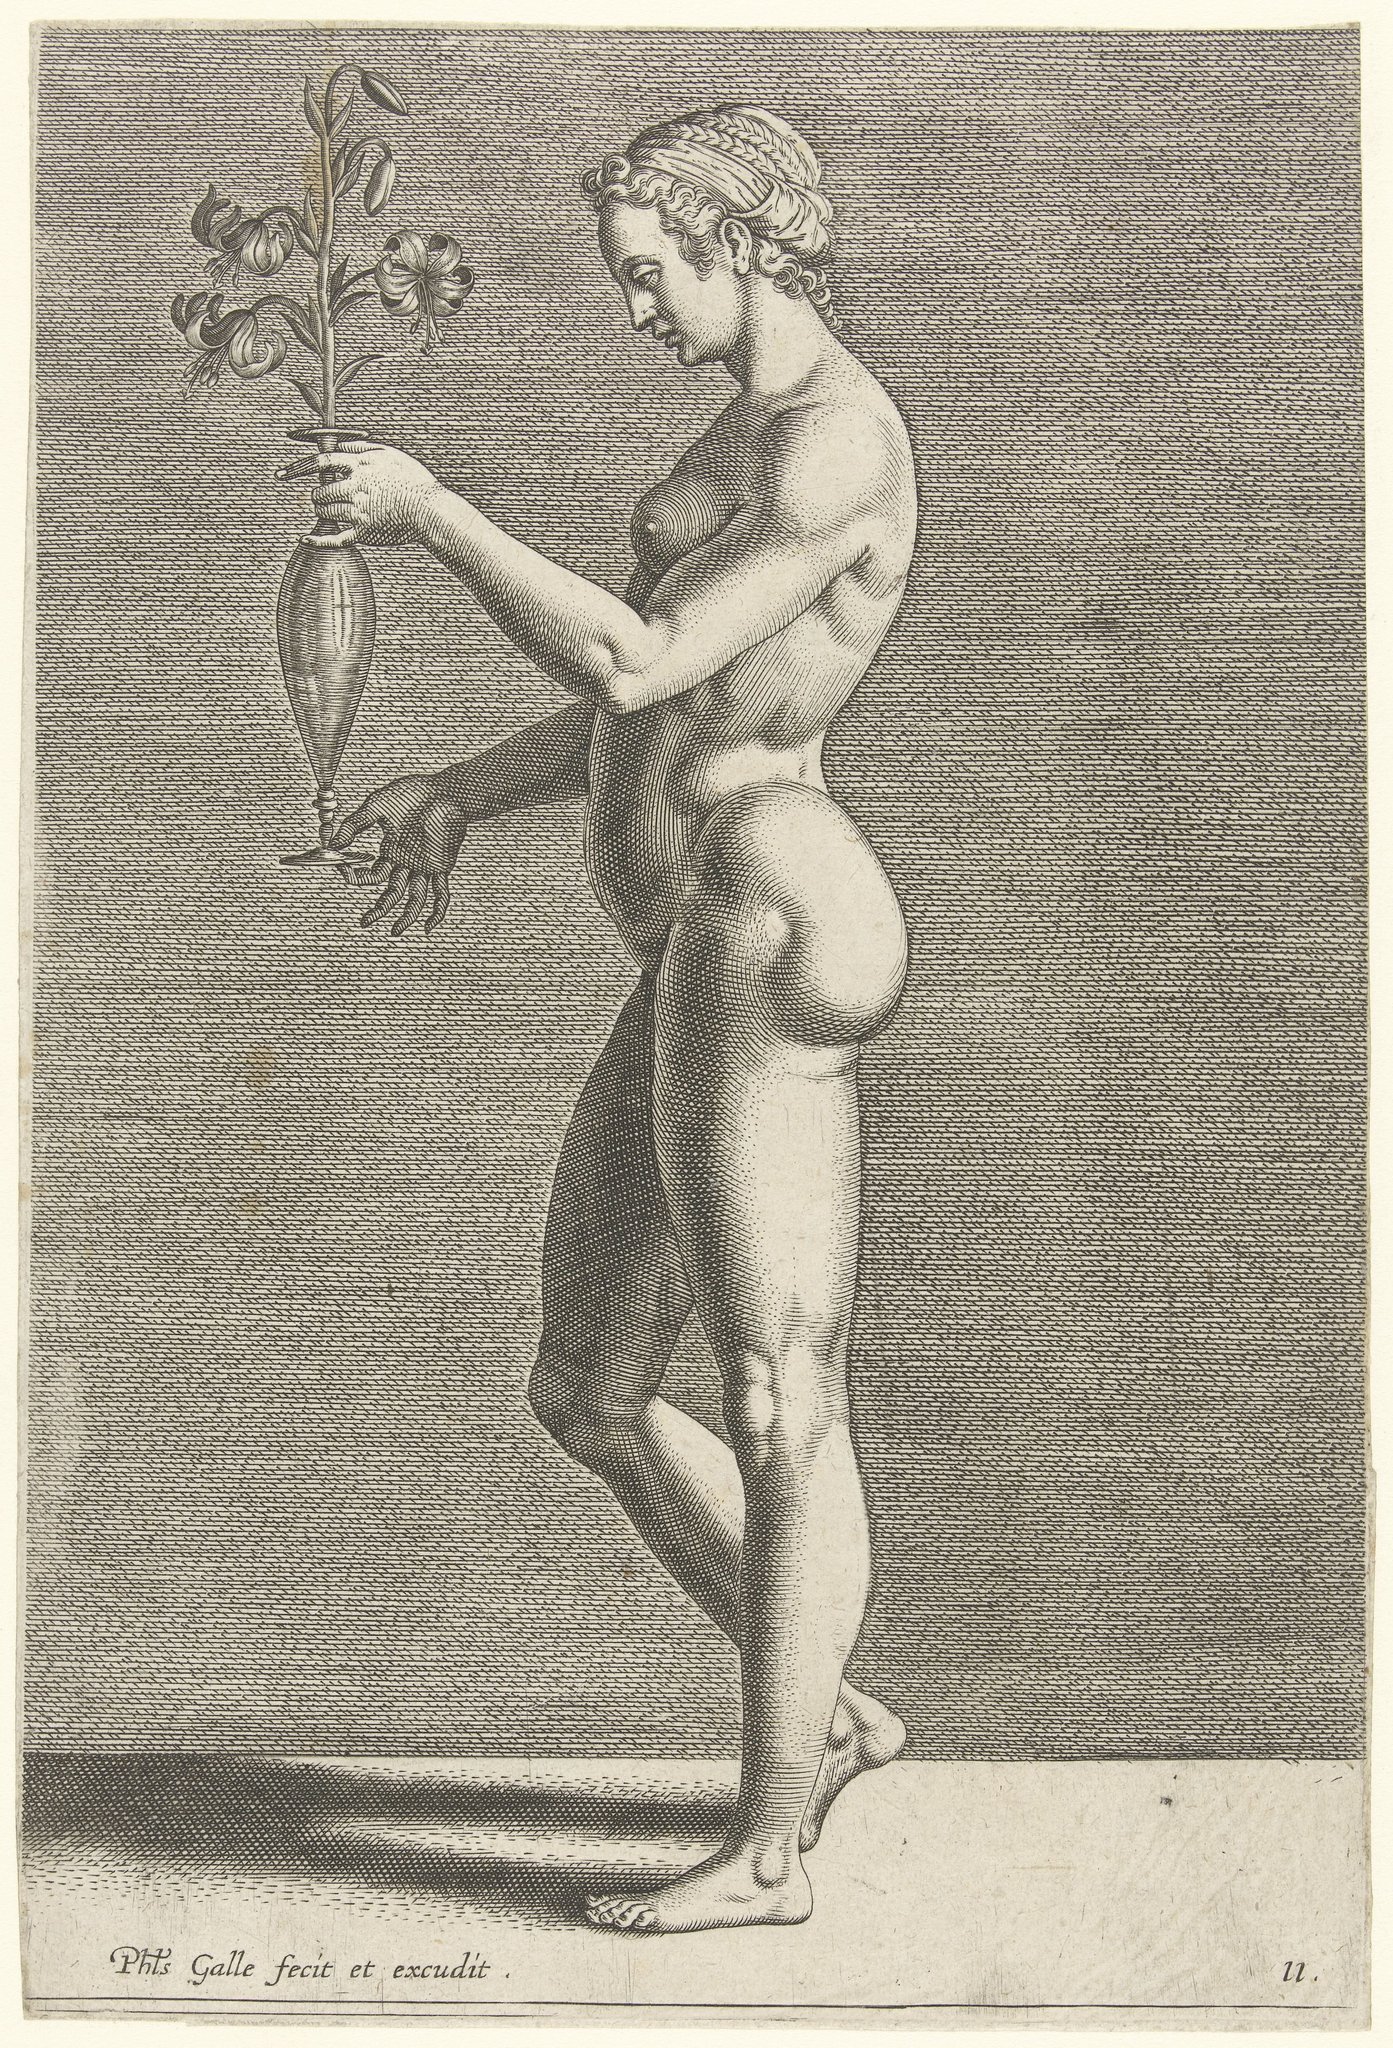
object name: print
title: Instructions et fondements de bien pourtraire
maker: philips galle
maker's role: print maker, publisher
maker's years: 1537-1612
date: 1589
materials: paper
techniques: engraving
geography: antwerp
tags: human figure of ideal proportions, e.g. academic nude - aa - female human figure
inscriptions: collector's mark: Lugt 2760, collector's mark: Lugt 2228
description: Staande naakte vrouwefiguur, in profiel naar links. In haar handen een tak lelies in een vaas. De prent maakt deel uit van een dertiendelige serie over de fundamenten van het tekenen.